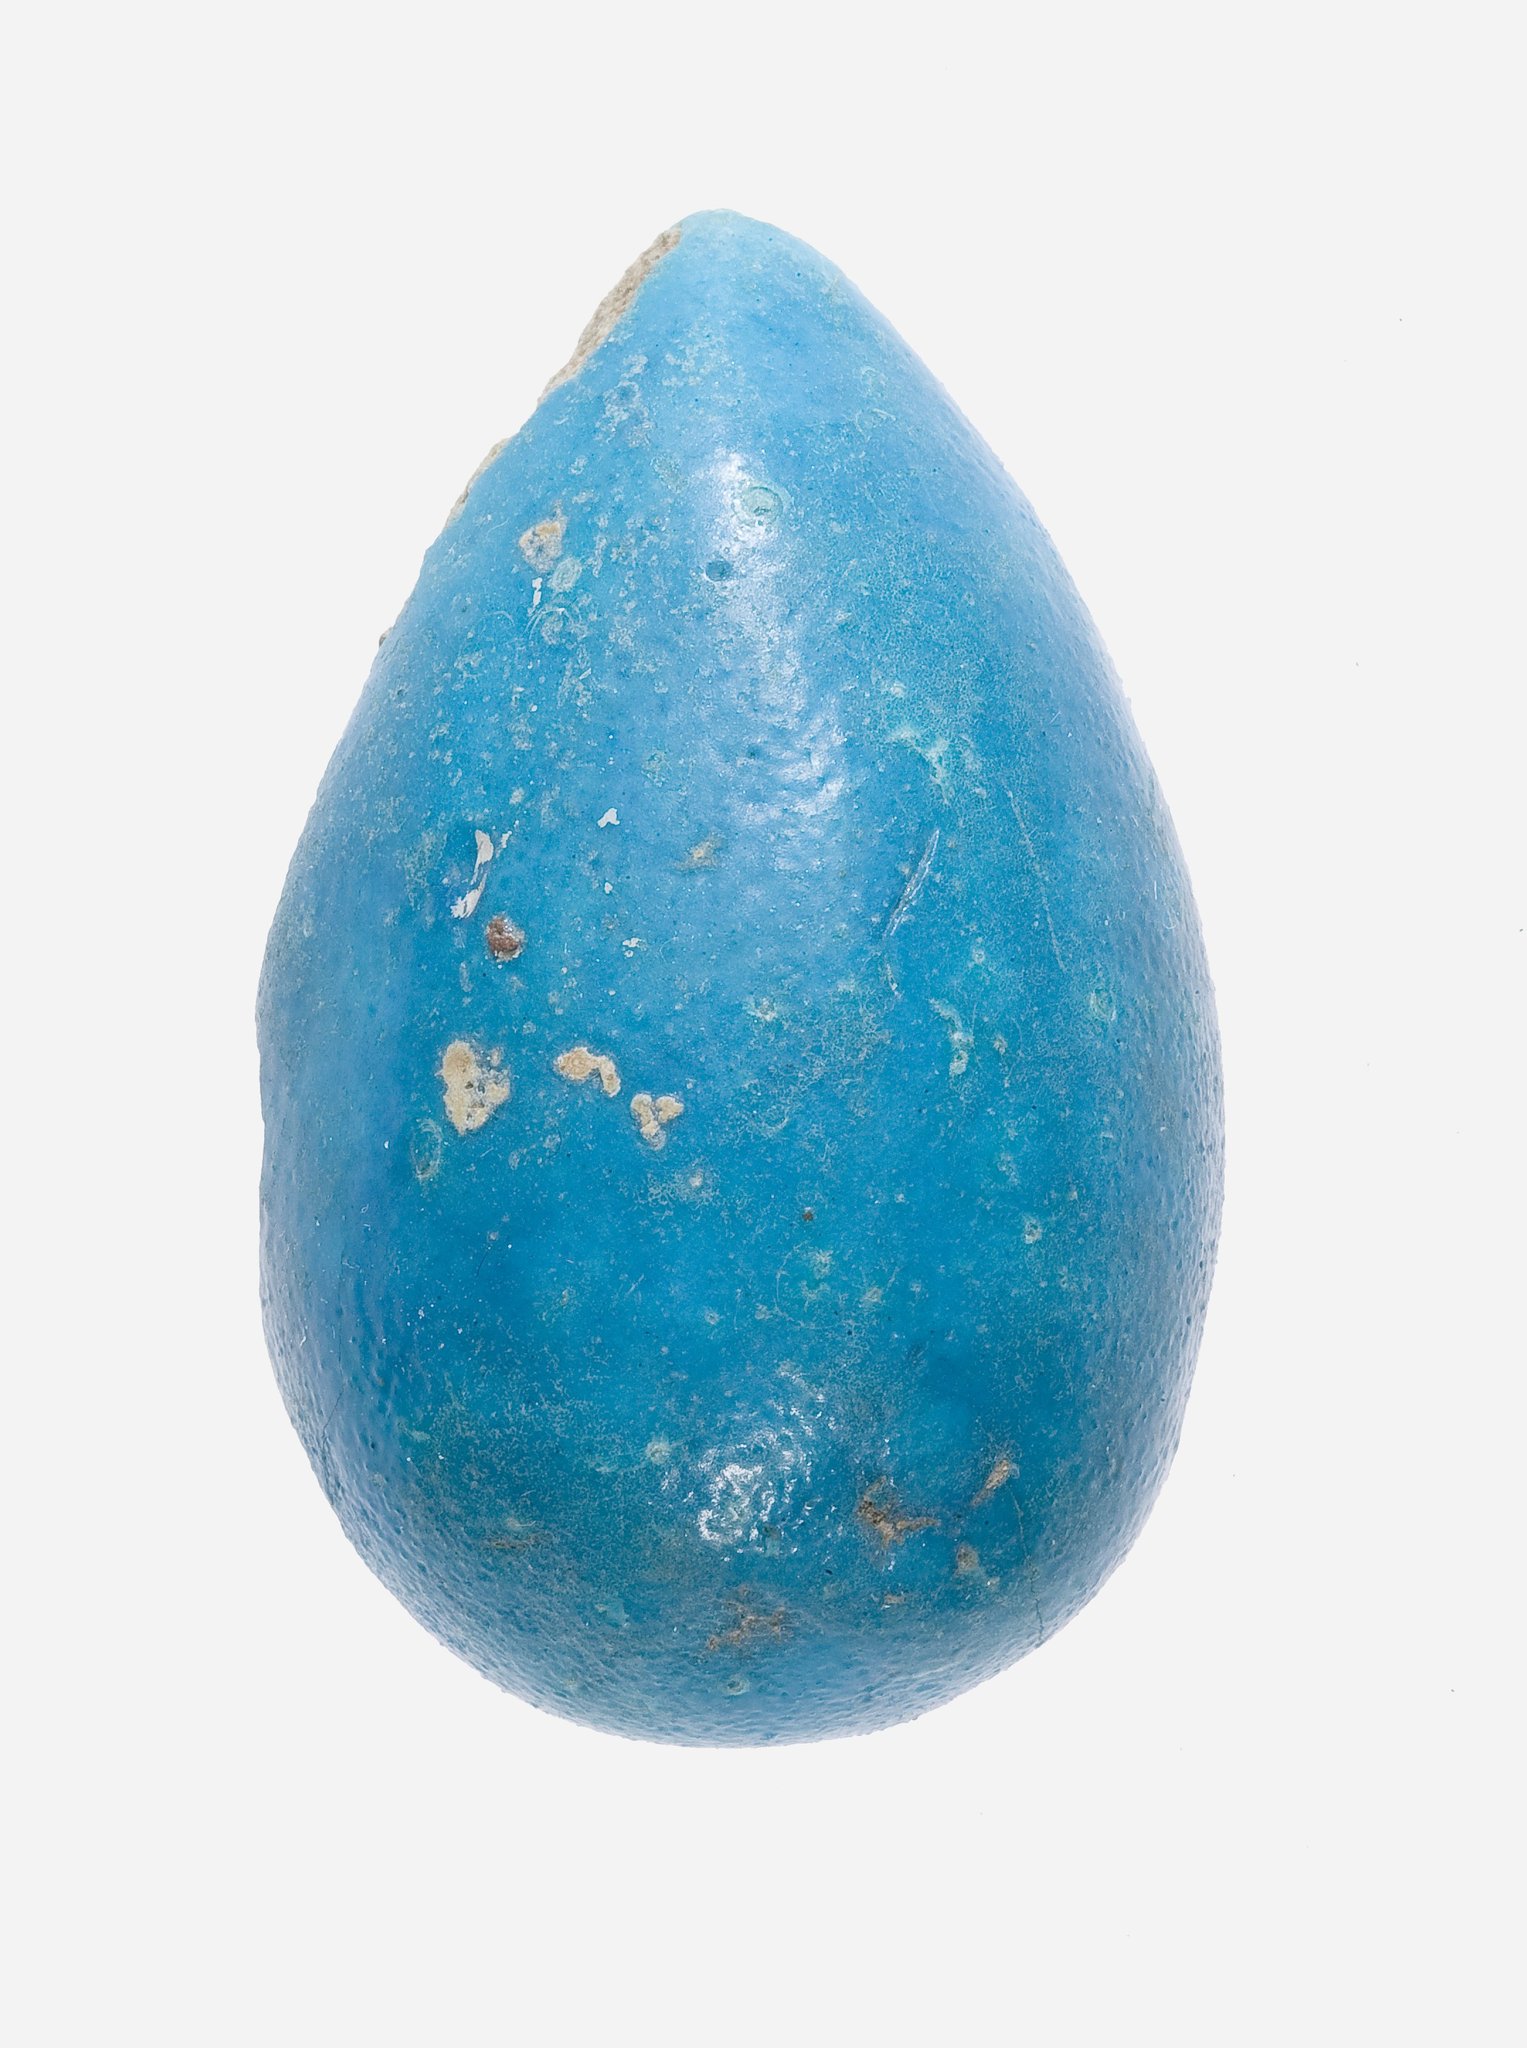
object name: ornament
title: Architectural Inlay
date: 1390-1352 BCE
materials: faience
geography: egypt